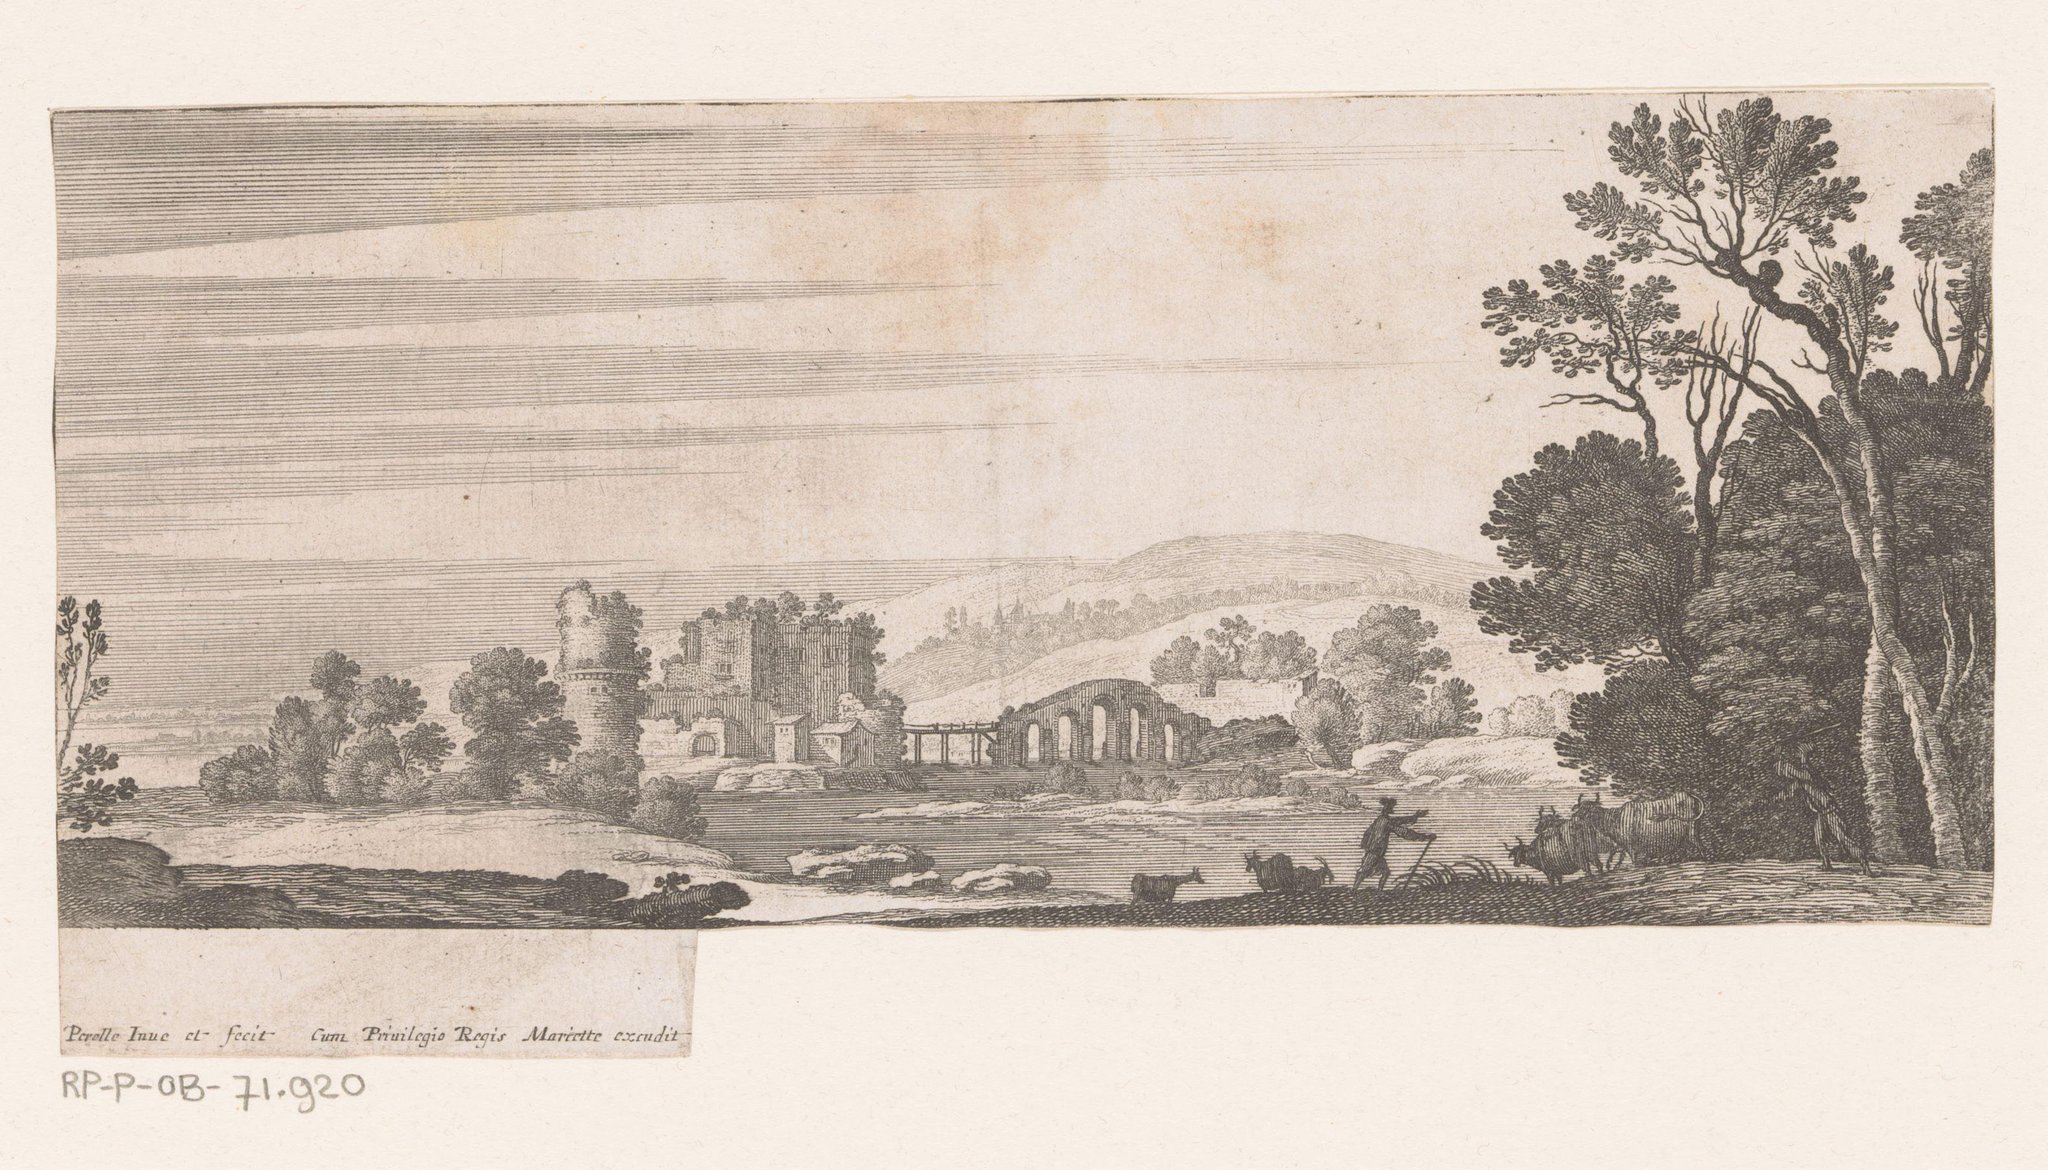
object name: print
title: Rivierlandschap met brug met vijf bogen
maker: mariette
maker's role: publisher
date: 1613-1695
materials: paper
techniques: engraving, etching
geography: paris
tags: river, herding, herdsman, herdswoman, shepherd, shepherdess, cowherd, etc., landscape with bridge, viaduct or aqueduct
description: Prenten met het signatuur 'Perelle' kunnen zowel door vader Gabriel als door zonen Nicolas en Adam gemaakt zijn.